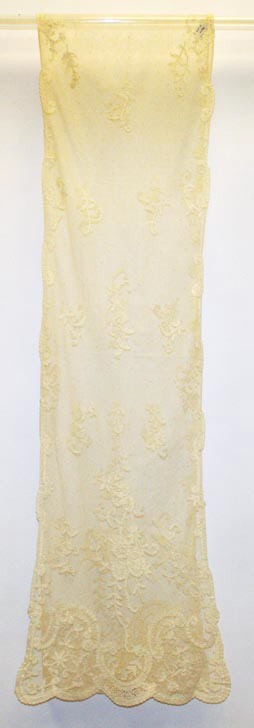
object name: scarf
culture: belgian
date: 1801-1900